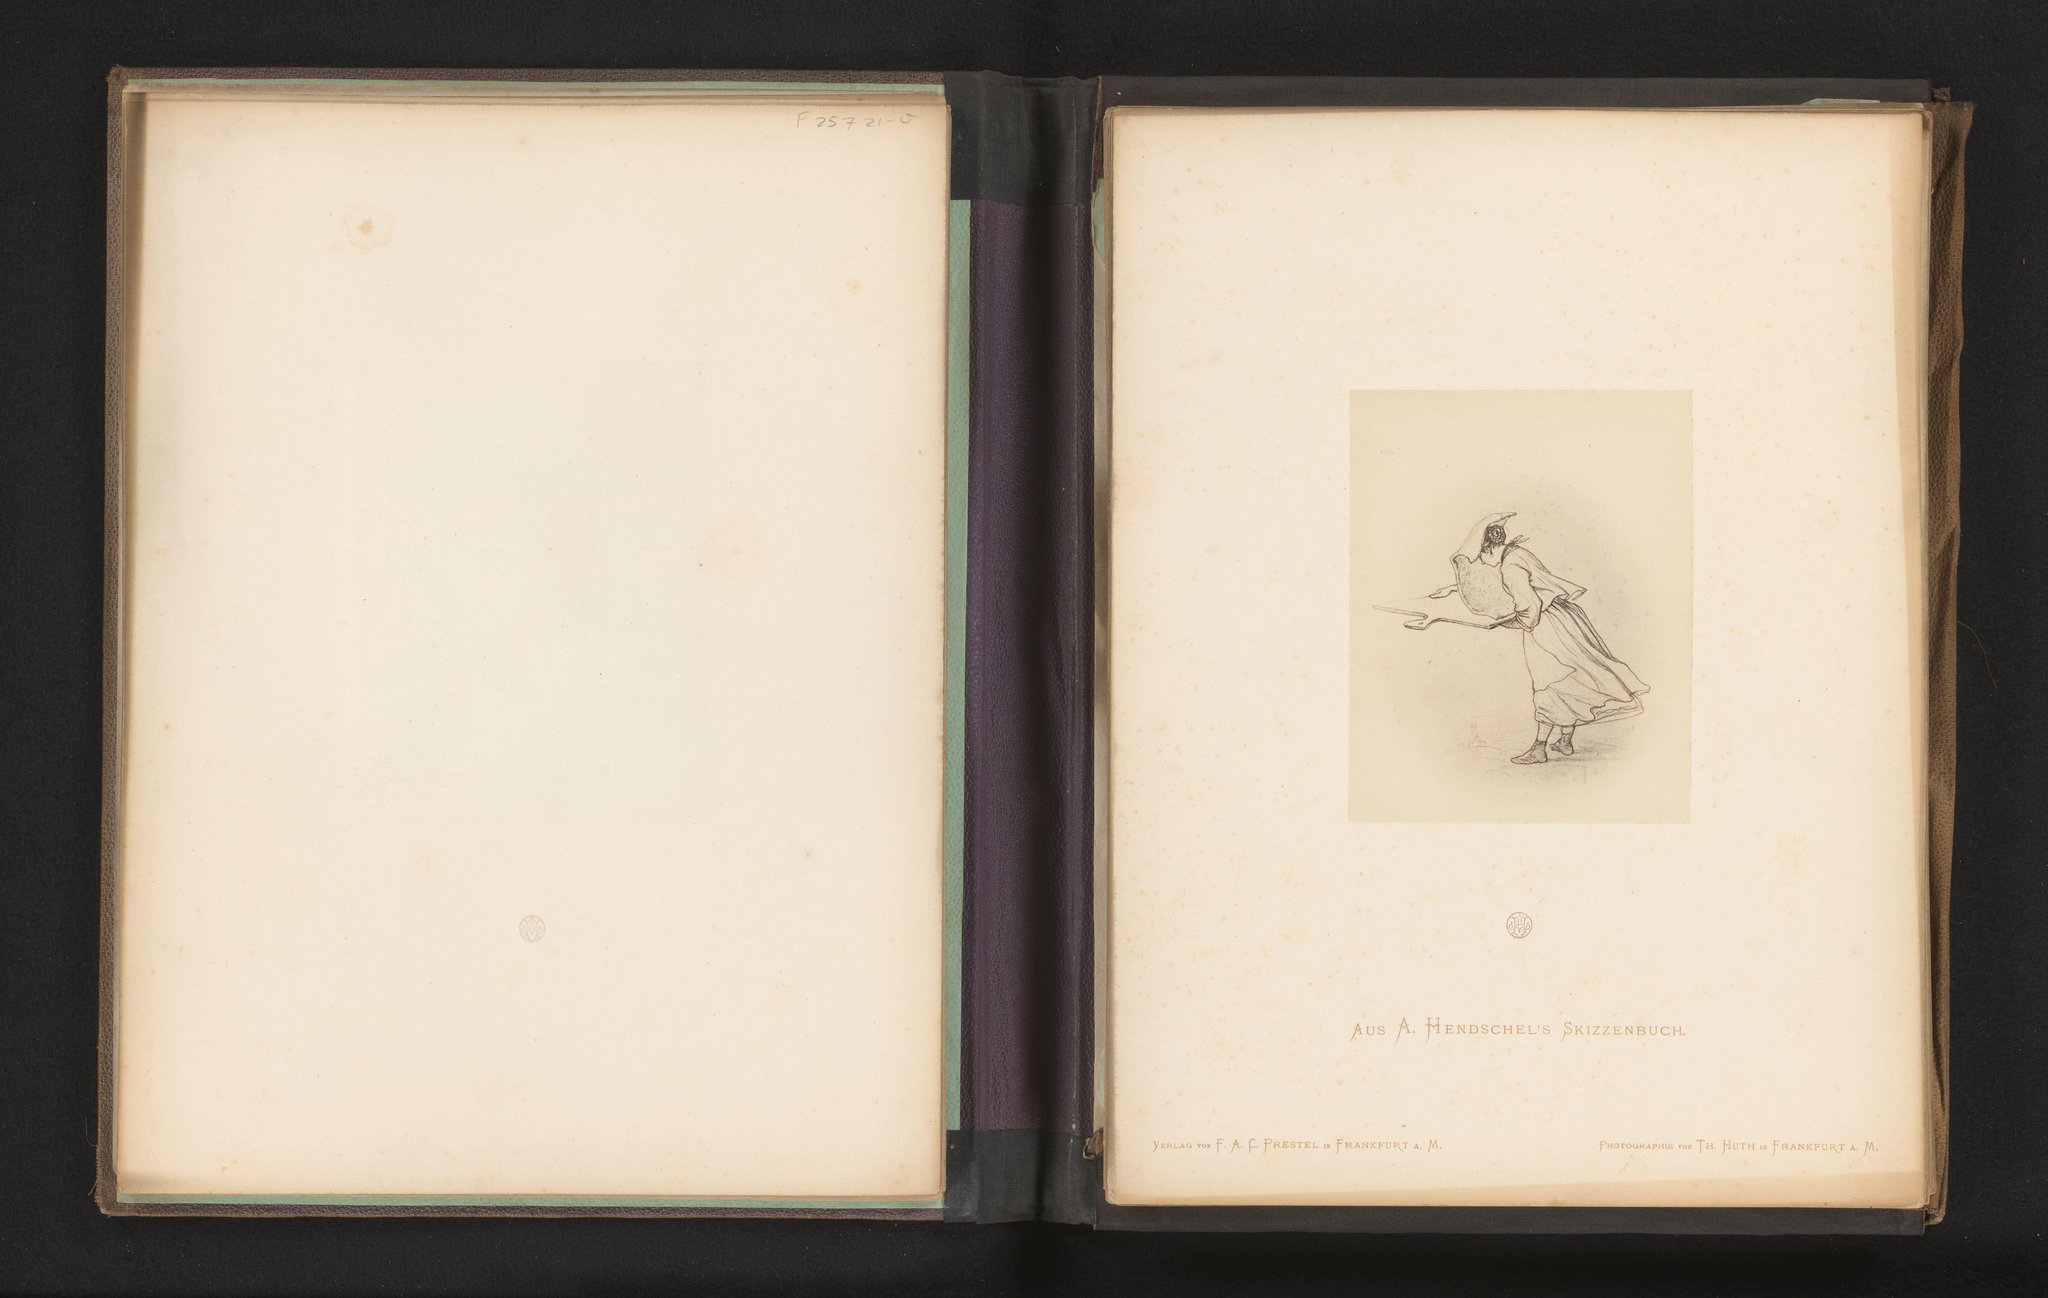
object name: reproduction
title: Fotoreproductie van een schets van een dienstmeisje in een storm door Albert Hendschel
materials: paper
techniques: albumen print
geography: frankfurt am main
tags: storm, kitchen-maid, kitchen servant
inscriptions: monogram: ‘AH’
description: Deze foto maakt deel uit van een omslag met 50 foto's op 48 bladen, een lijst van afbeeldingen en een titelblad.